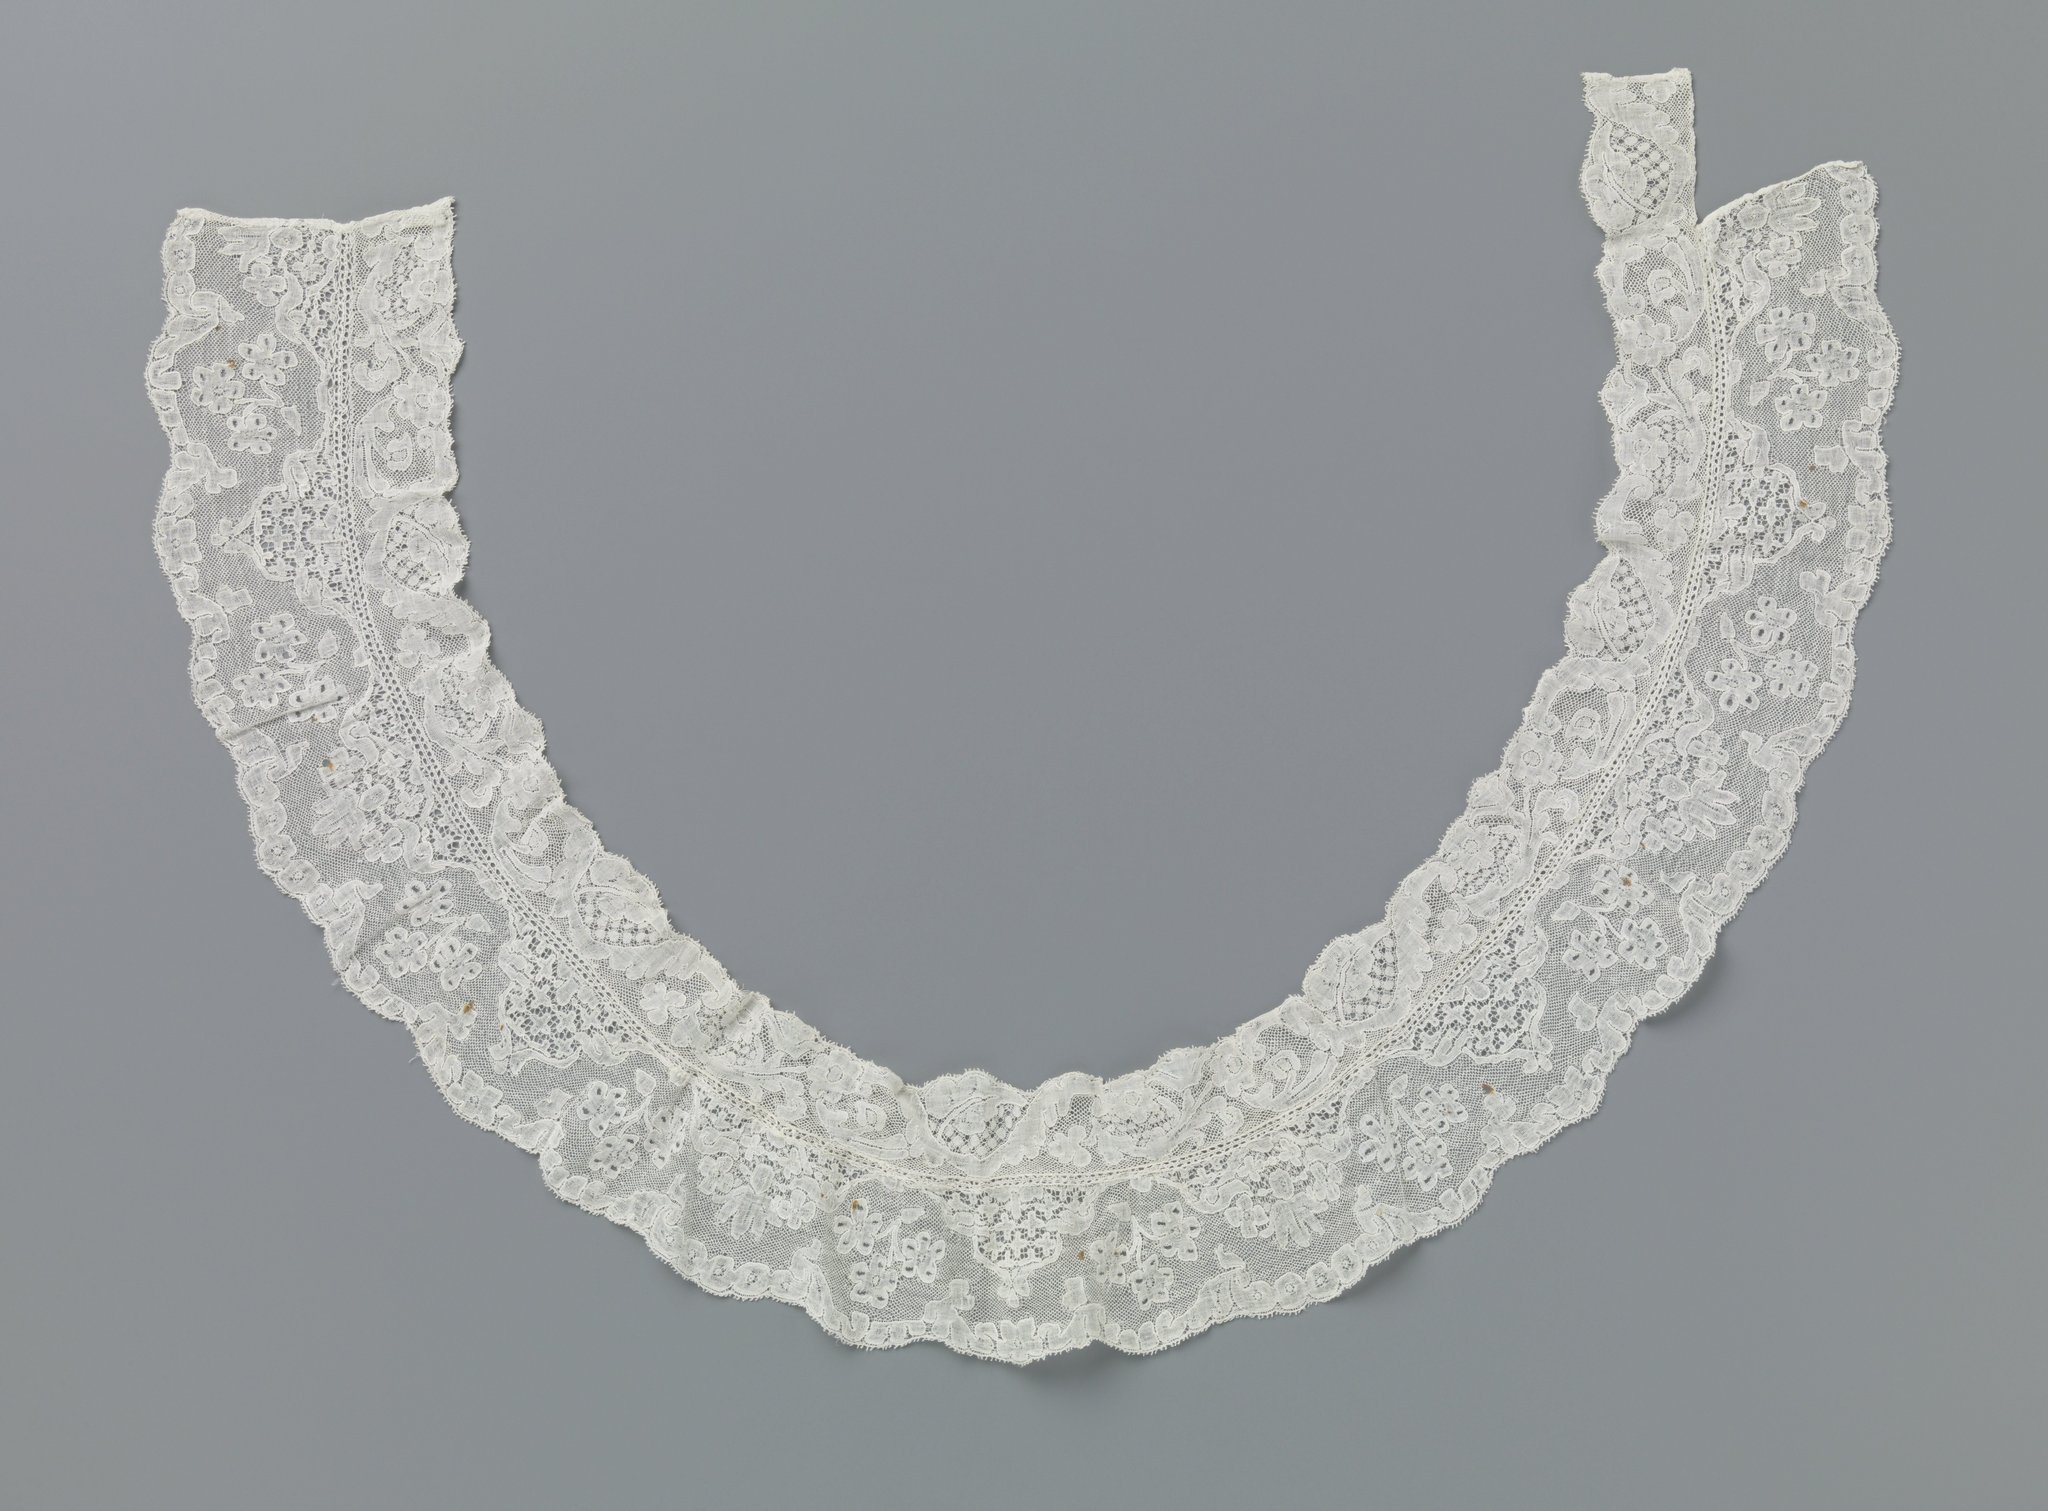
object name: collar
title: Dubbele kraag van kloskant met berg en dal-lijn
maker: Anonymous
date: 1740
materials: linen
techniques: lace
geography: southern netherlands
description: Op een fijne traliegrond, een Mechelse grond (ook wel ijsgrond genoemd), staat een symmetrisch patroon. Binnen een gerekte schulprand van gelobde bladeren en roosjes staan drievoudige bloemtakken ter weerszij van een bladrozet onder een 'berg-en dal'-lijn. Deze begrenst twee gehalveerde ruitvormige medaillons met een rastervulling van kruisbloempjes. Het smalle strookje van de kraag vertoont een lopend patroon van een bloemrank tussen omega-vormige gelobde ranken. Mechelse kant.